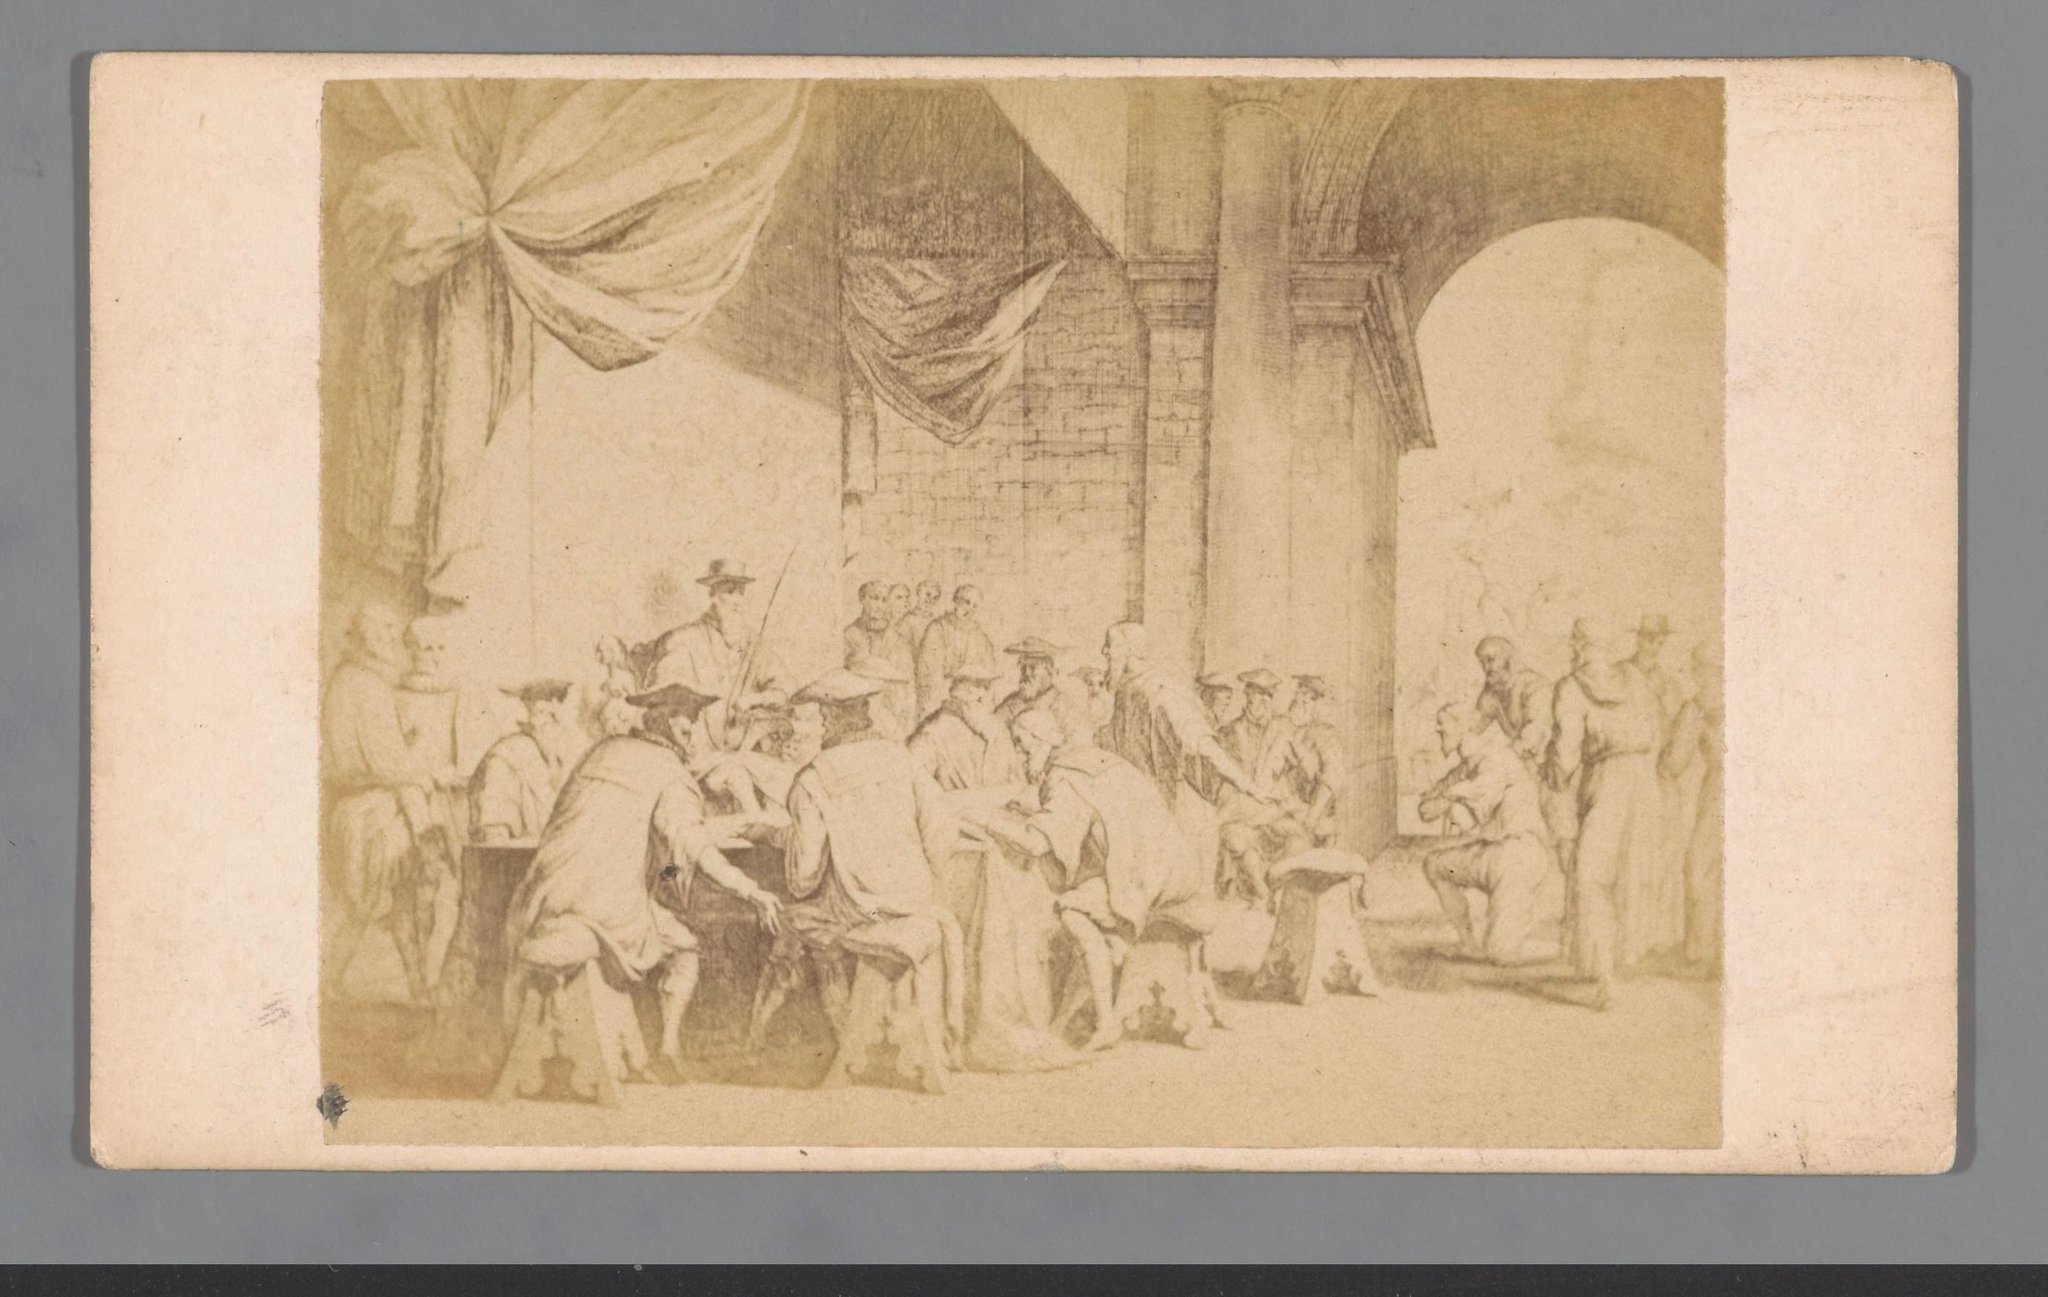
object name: carte de visite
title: Fotoreproductie van een gravure van De Raad der Beroerten ofwel de Bloedraad, door de hertog van Alva in september 1567 ingesteld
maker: Anonymous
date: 1850-1900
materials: cardboard, photographic support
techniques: albumen print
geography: netherlands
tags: fernando álvarez de toledo (3rd duke of alba), persecution of heretics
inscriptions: number: ‘7’, inscription: ‘De Spaansche (...) Bloedraad bestempelde.’